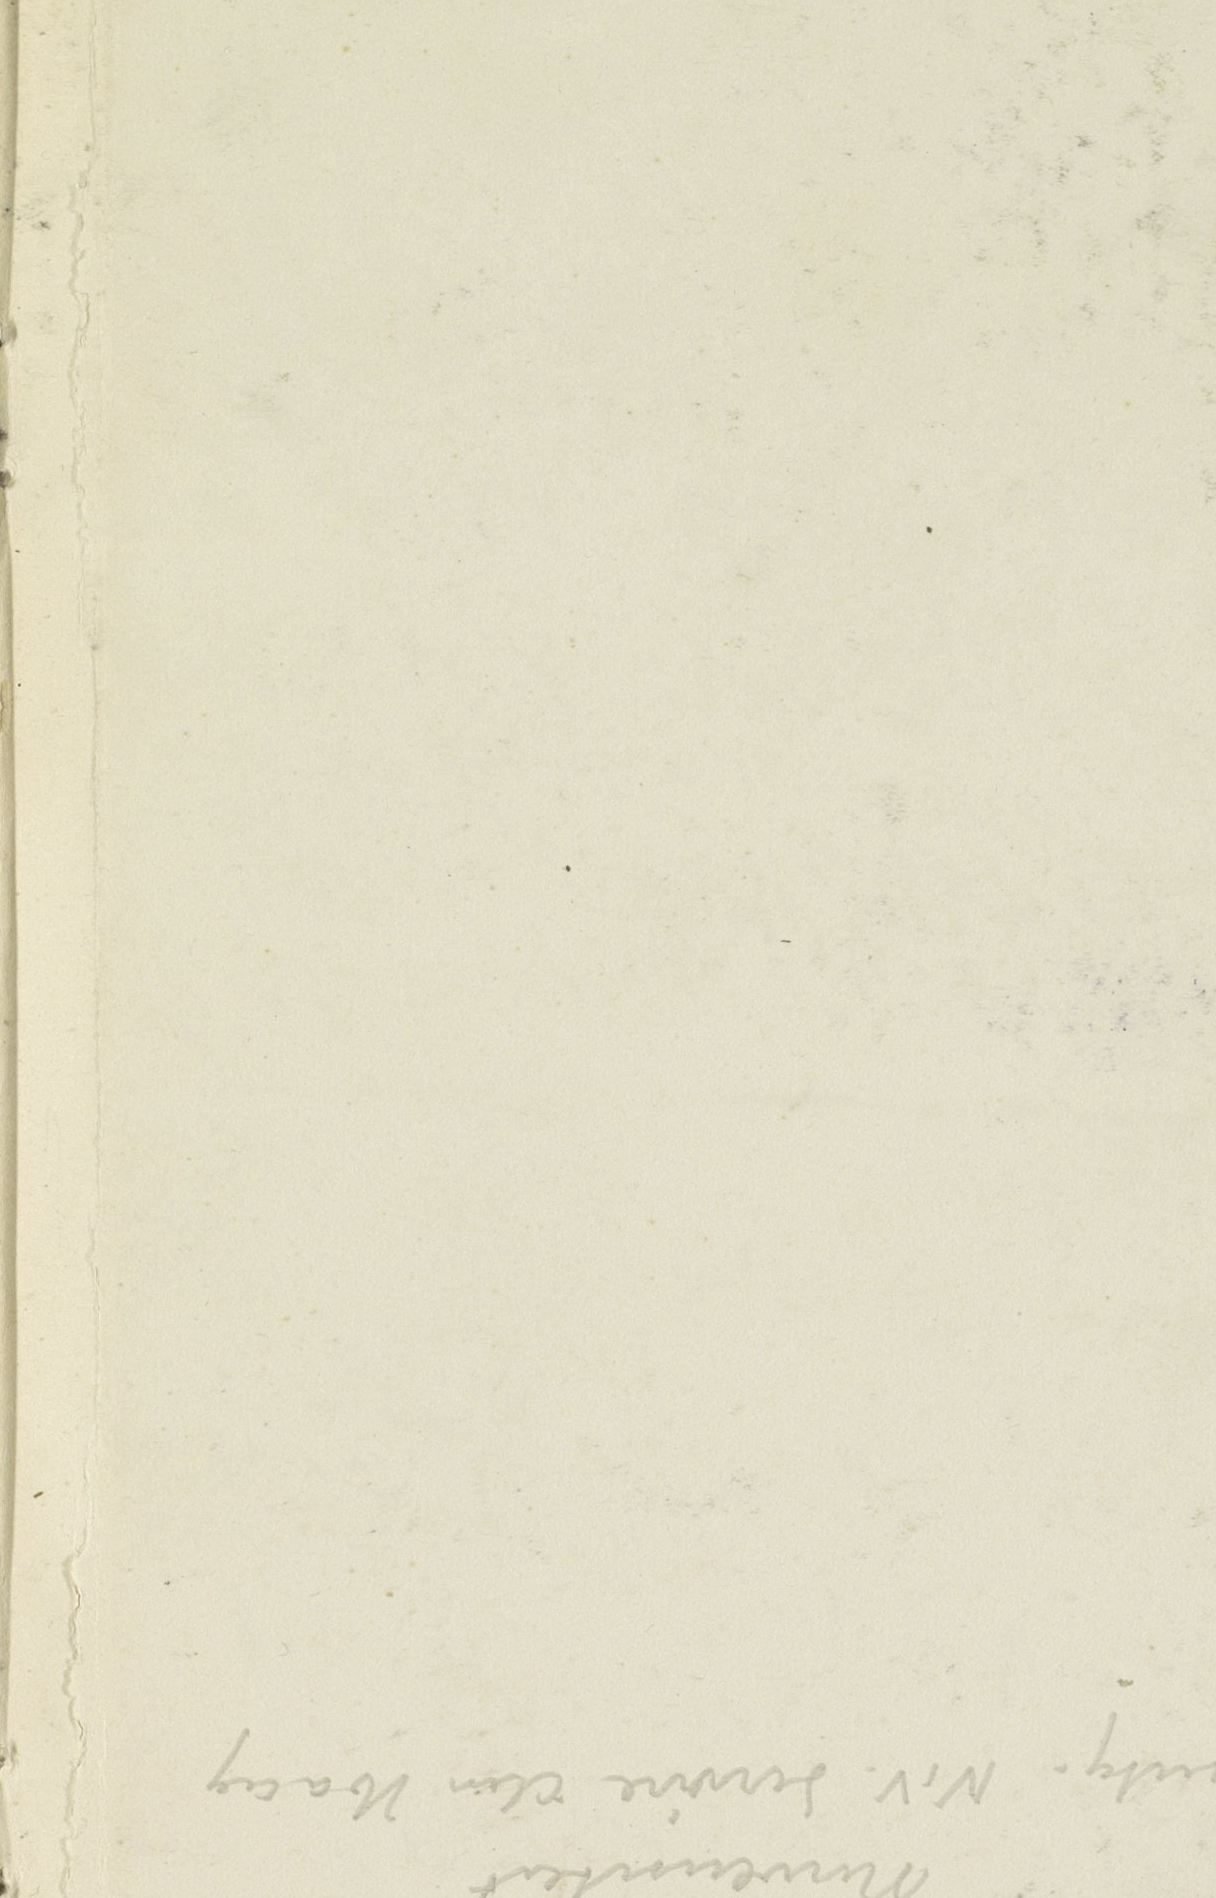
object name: endleaf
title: Notities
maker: cornelis vreedenburgh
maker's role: draughtsman, print maker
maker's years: 1880-1946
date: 1890-1946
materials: paper, pencil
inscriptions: annotation: ‘[...]’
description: Achterste schutblad uit een schetsboek met 73 bladen.